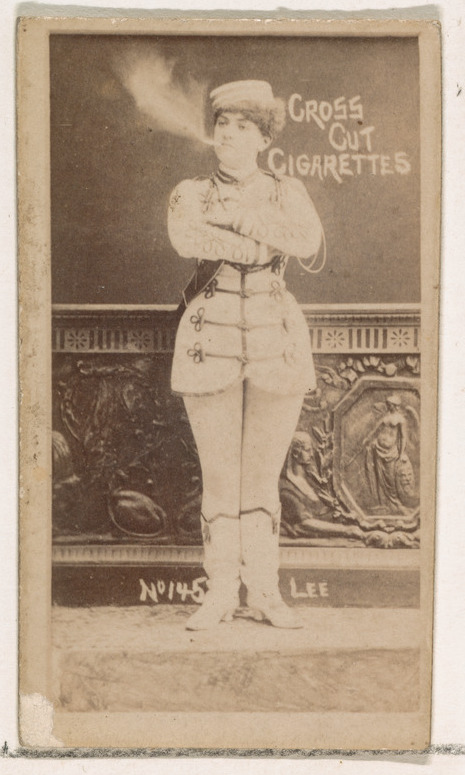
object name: print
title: Card Number 145, Lee, from the Actors and Actresses series (N145-1) issued by Duke Sons & Co. to promote Cross Cut Cigarettes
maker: w. duke, sons & co.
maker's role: publisher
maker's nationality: american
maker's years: 1870-1920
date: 1880-1889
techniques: albumen silver print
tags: portraits,women,smoking,actresses